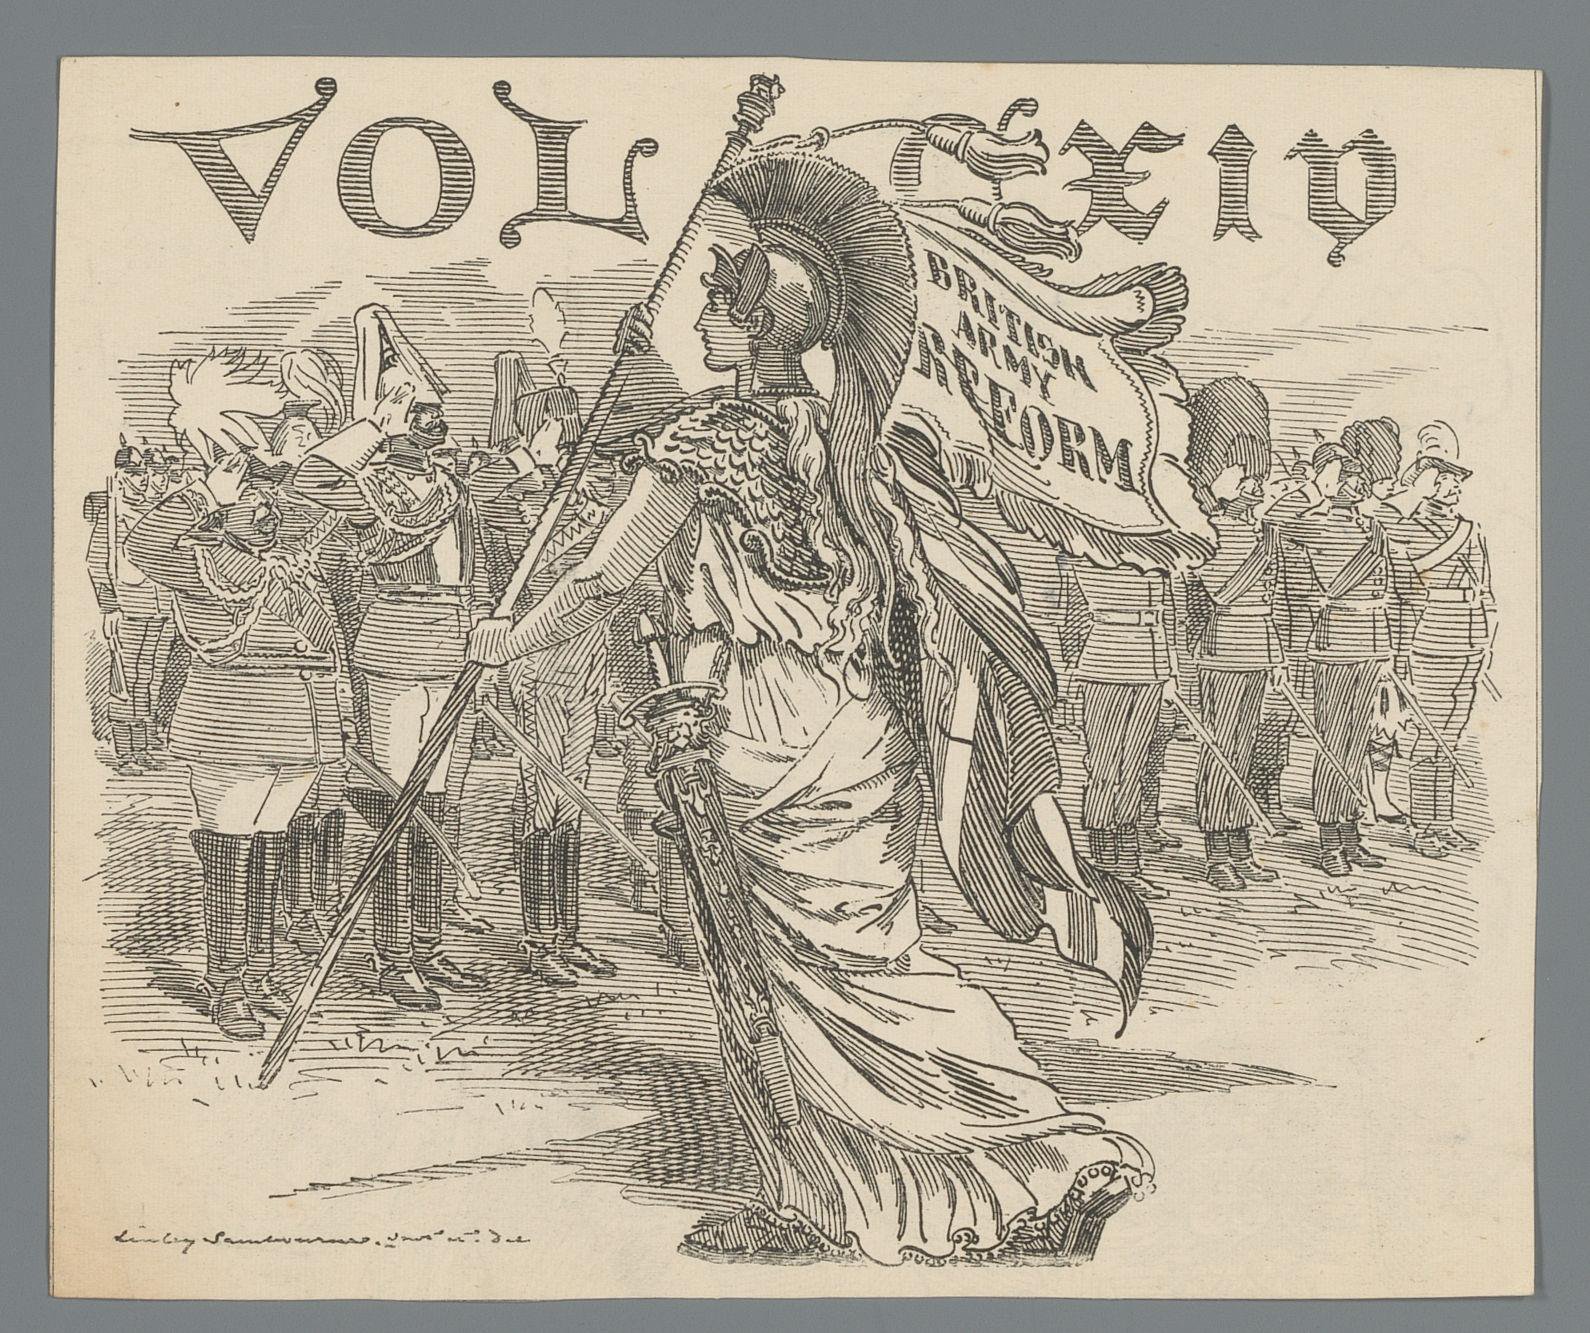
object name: cartoon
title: Vignet uit Punch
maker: edward linley sambourne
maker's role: draughtsman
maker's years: 1844-1910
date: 1898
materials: paper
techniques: line block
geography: england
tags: personifications of countries, nations, states, districts, etc., political caricatures and satires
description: Britannia met vaandel voor de troepen. Vignet uit het Engelse satirische tijdschrift Punch, vol. 114, 1898. Op de achterzijde enkele schetsen van koppen.